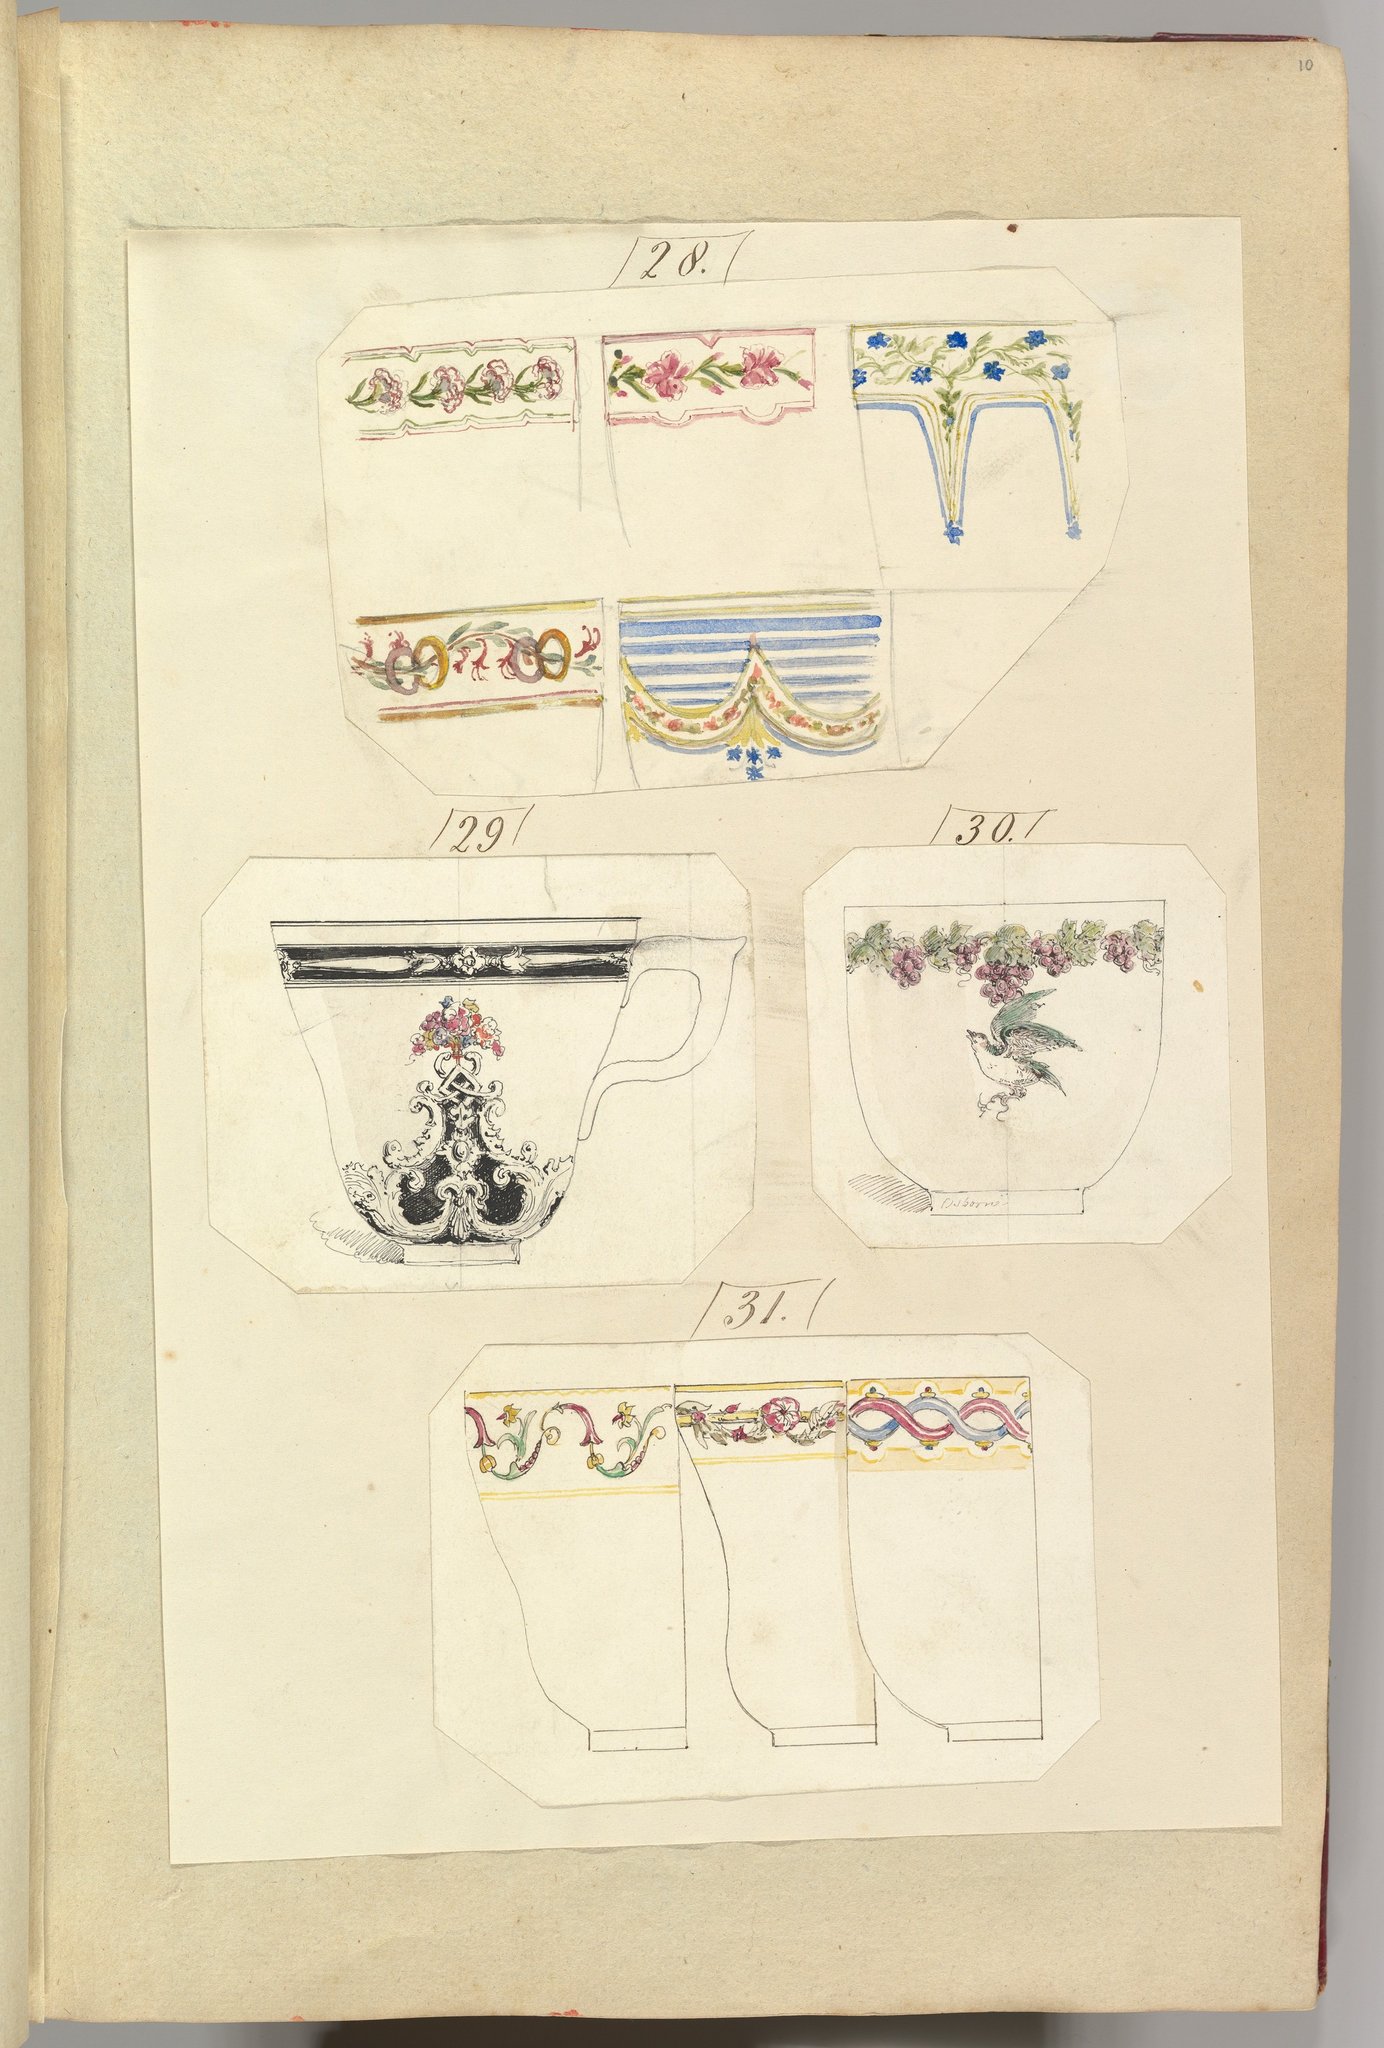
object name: drawing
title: Ten Designs for Decorated Cups, including Osborne Pattern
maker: alfred henry forrester [alfred crowquill]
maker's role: artist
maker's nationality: british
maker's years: 1804-1872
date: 1845-1855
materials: ink, watercolor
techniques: pen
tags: ornament,cups